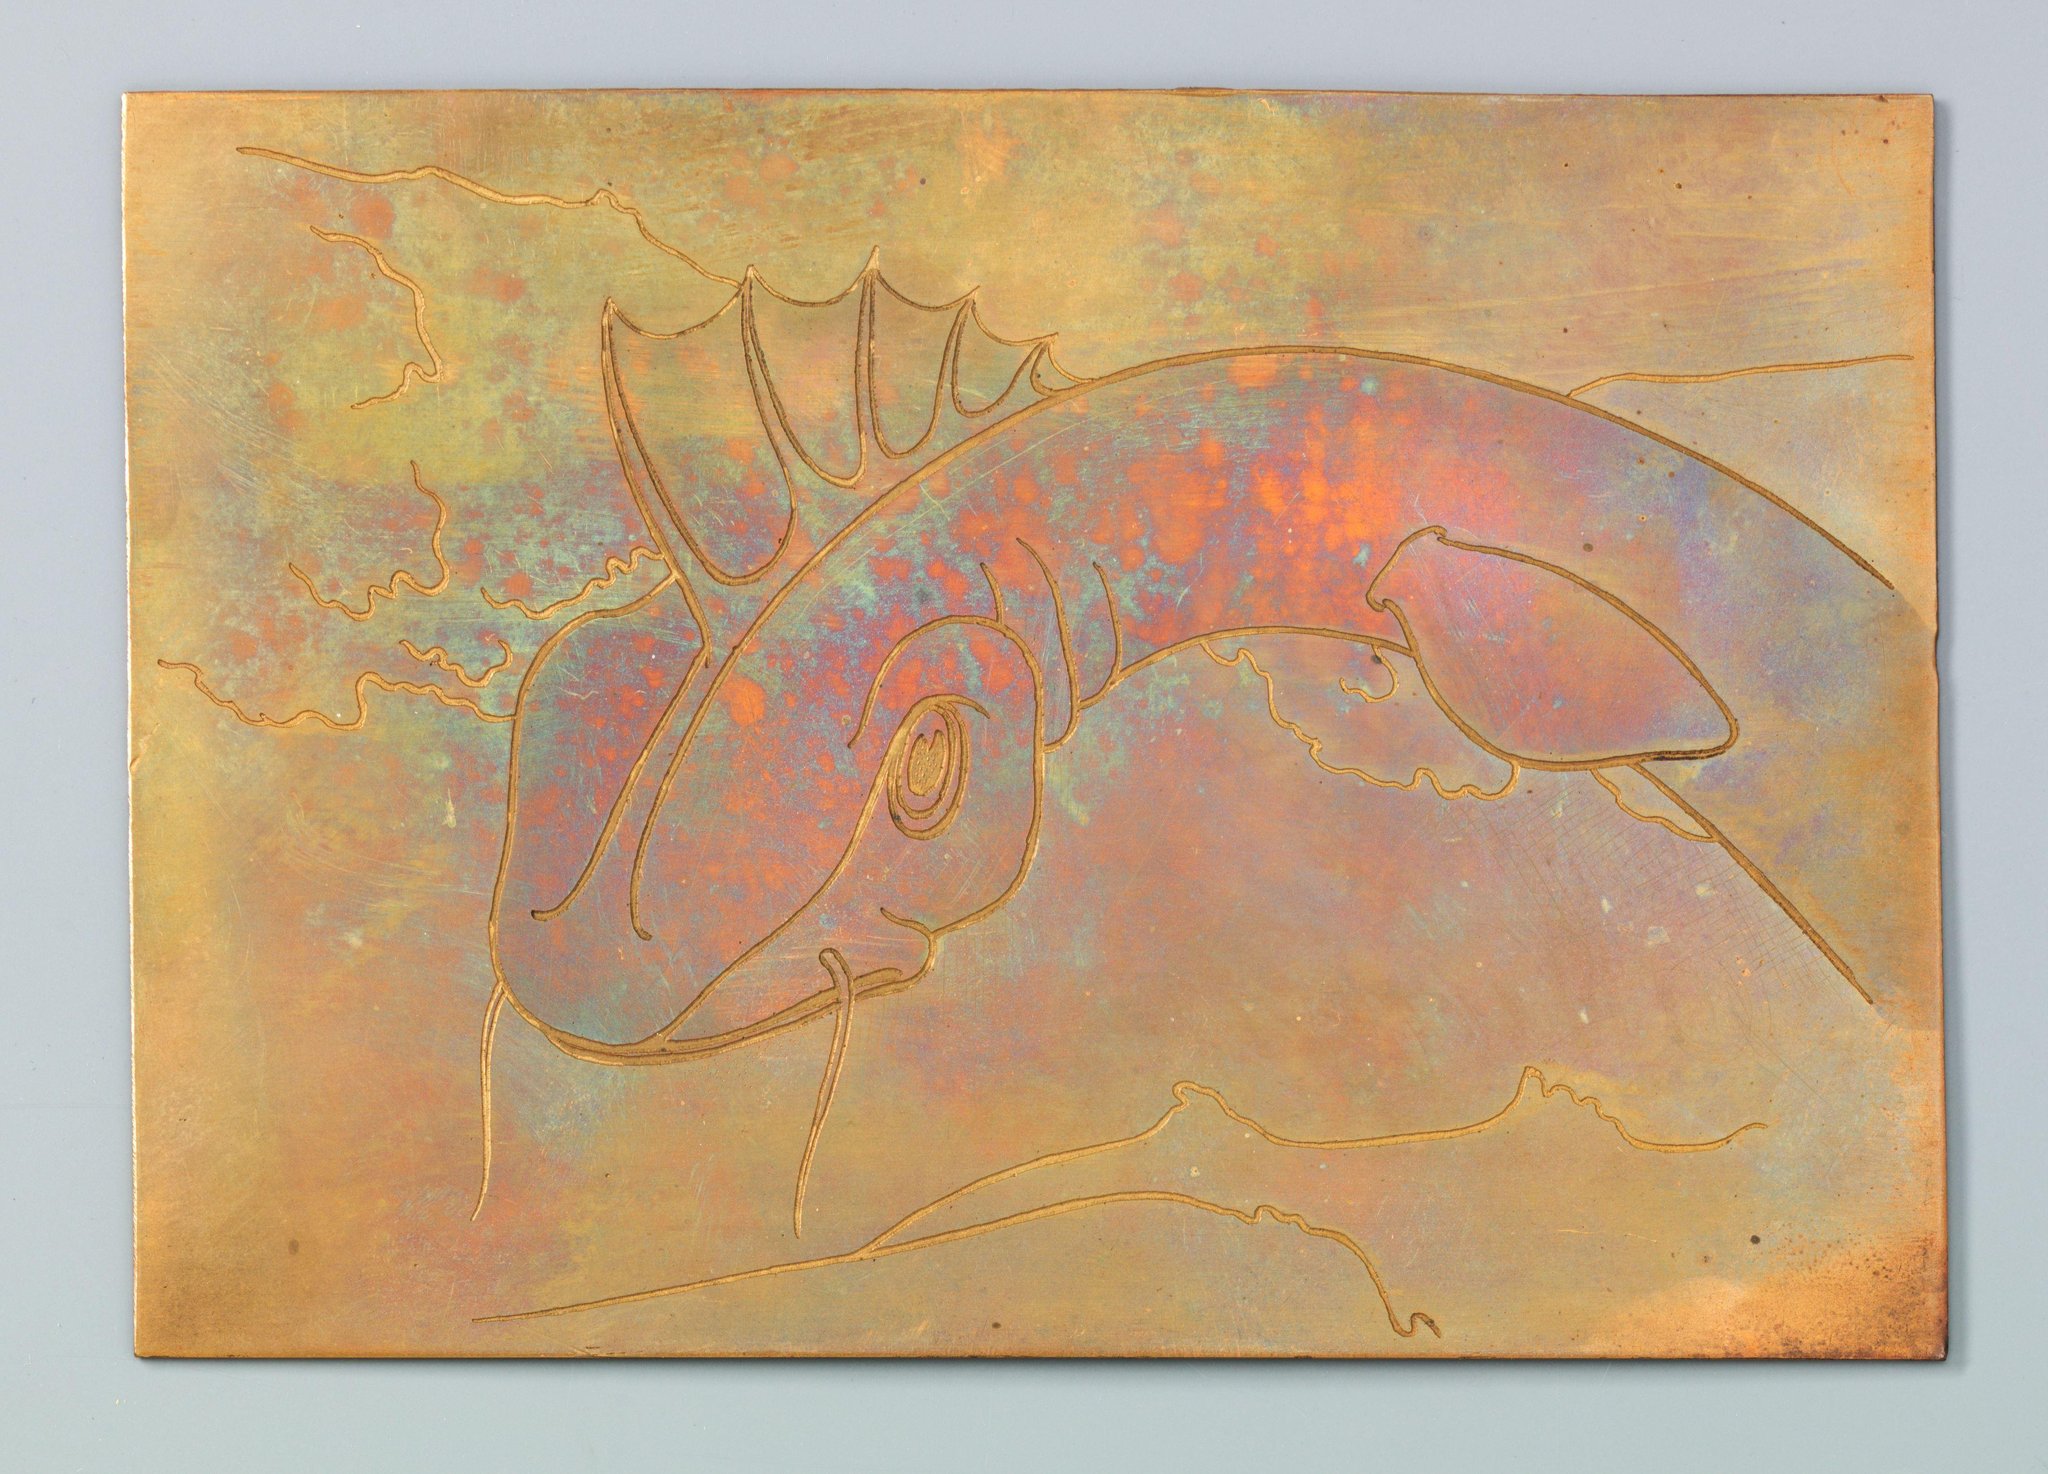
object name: messingplaat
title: Meerval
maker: samuel jessurun de mesquita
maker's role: draughtsman, print maker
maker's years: 1868-1944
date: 1878-1944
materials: brass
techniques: etching